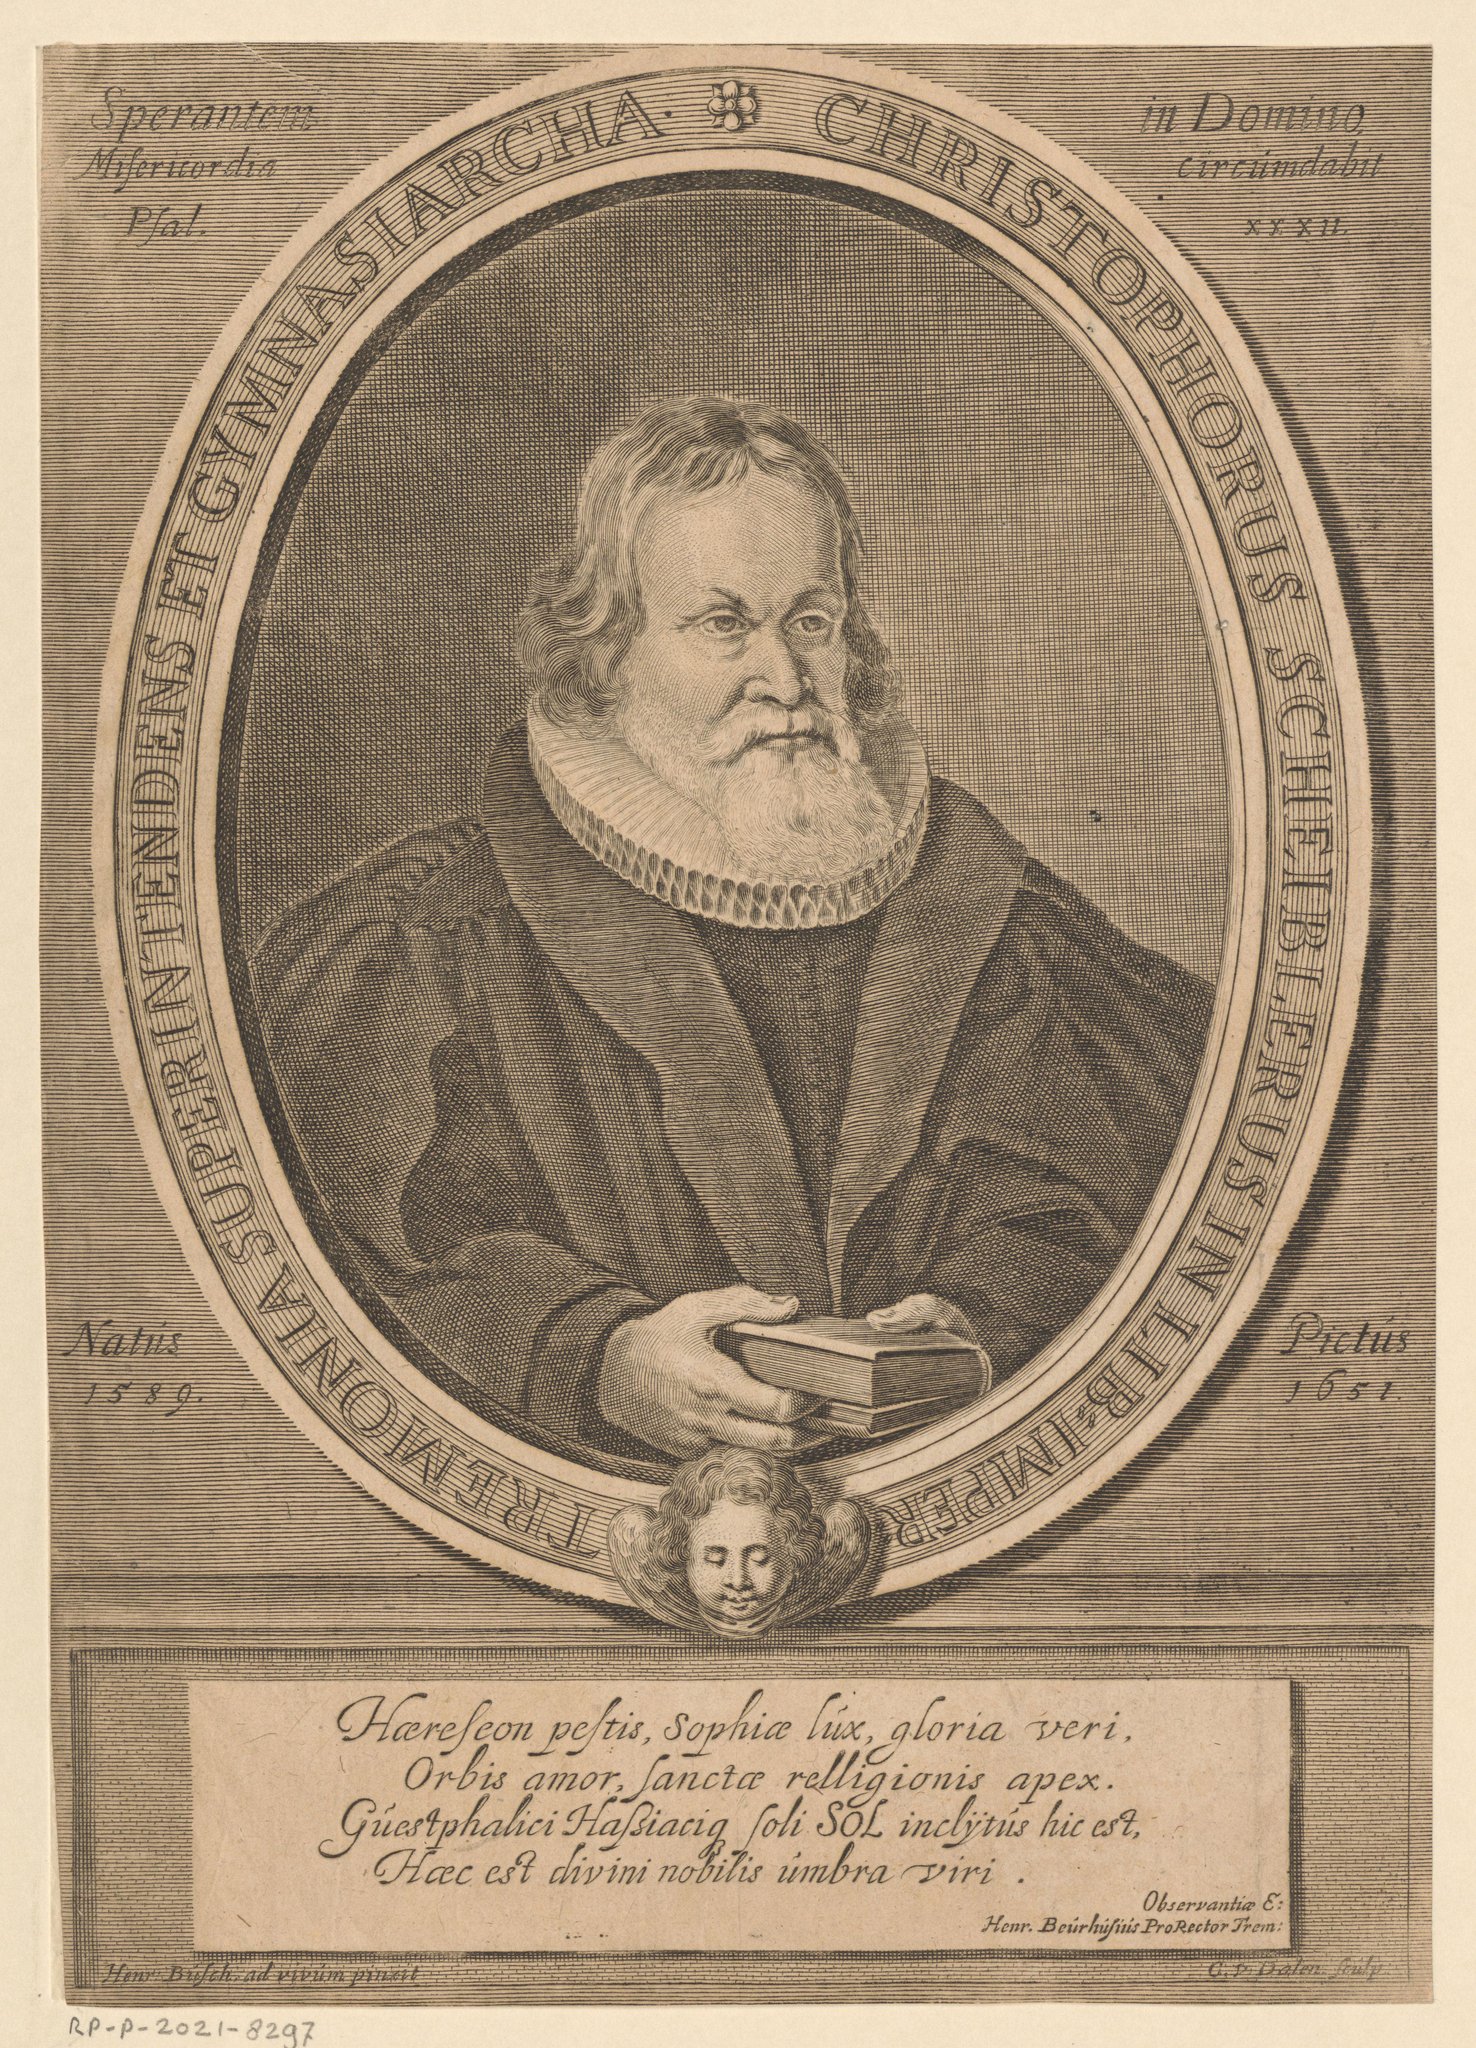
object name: print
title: Portret van Christoph Scheibler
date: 1651-1665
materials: paper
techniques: engraving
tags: theologian, historical persons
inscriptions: collector's mark: Lugt 2228